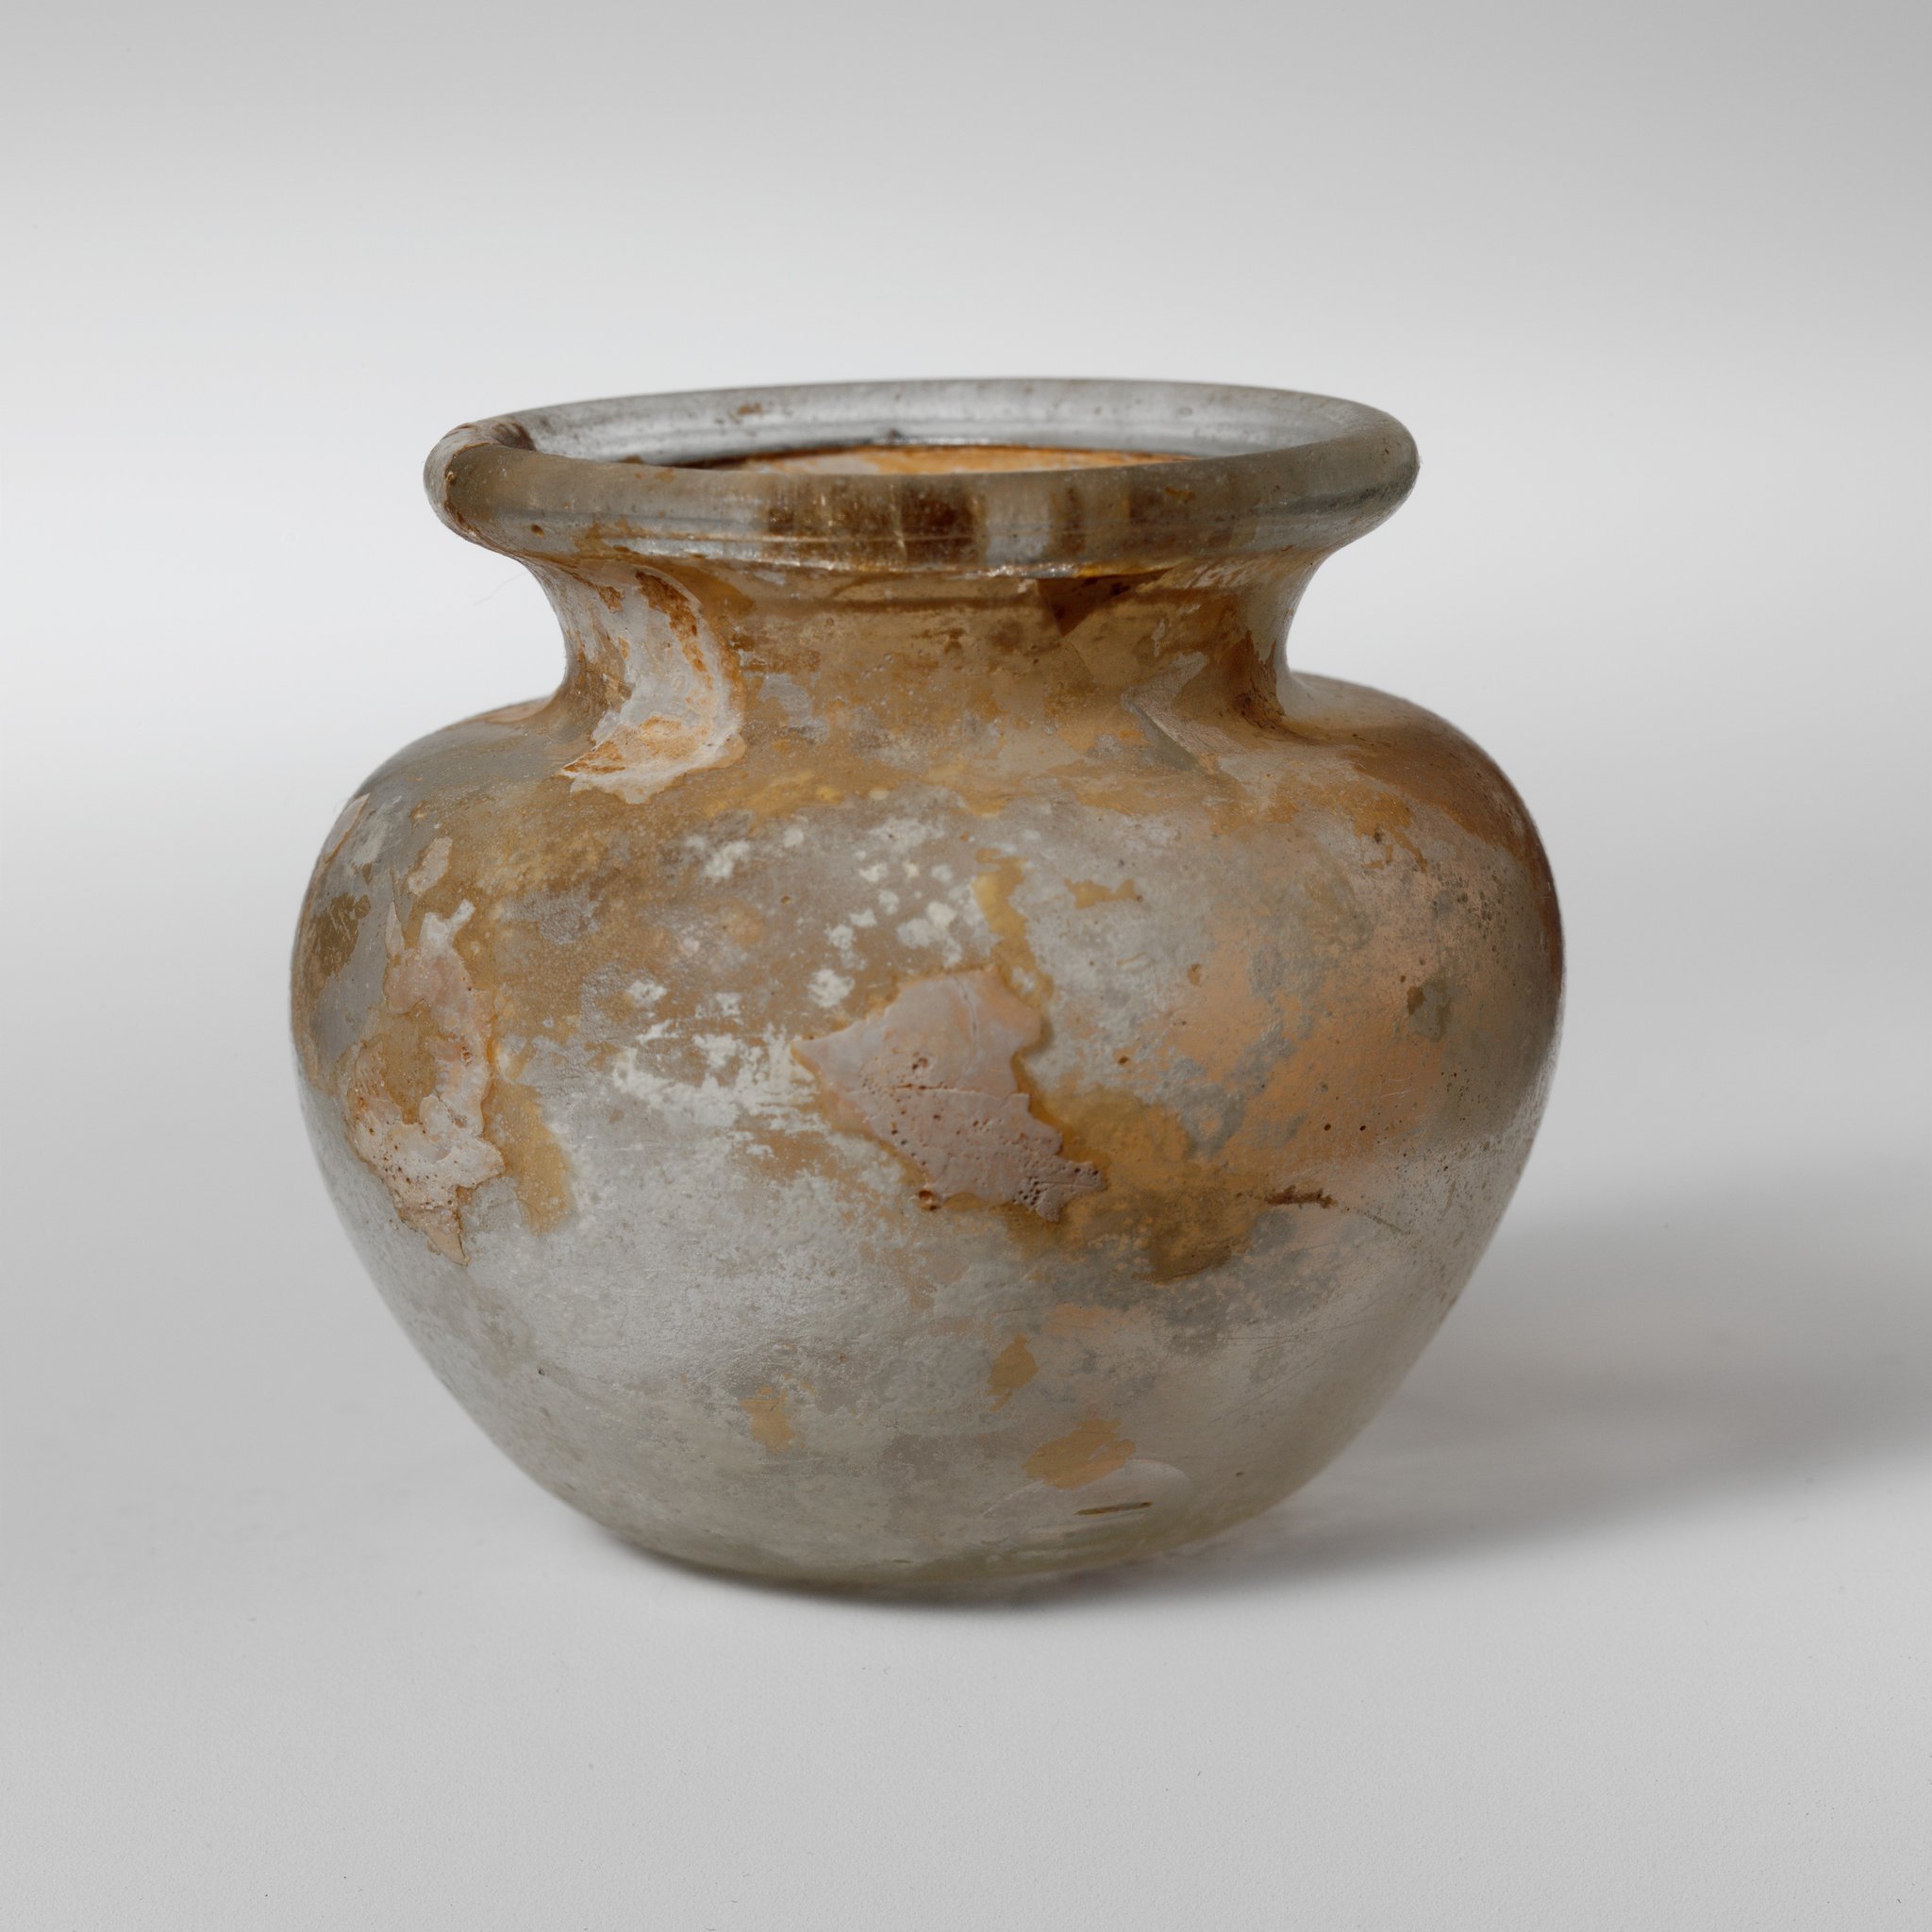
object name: jar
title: Glass miniature jar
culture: roman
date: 101-300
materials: glass